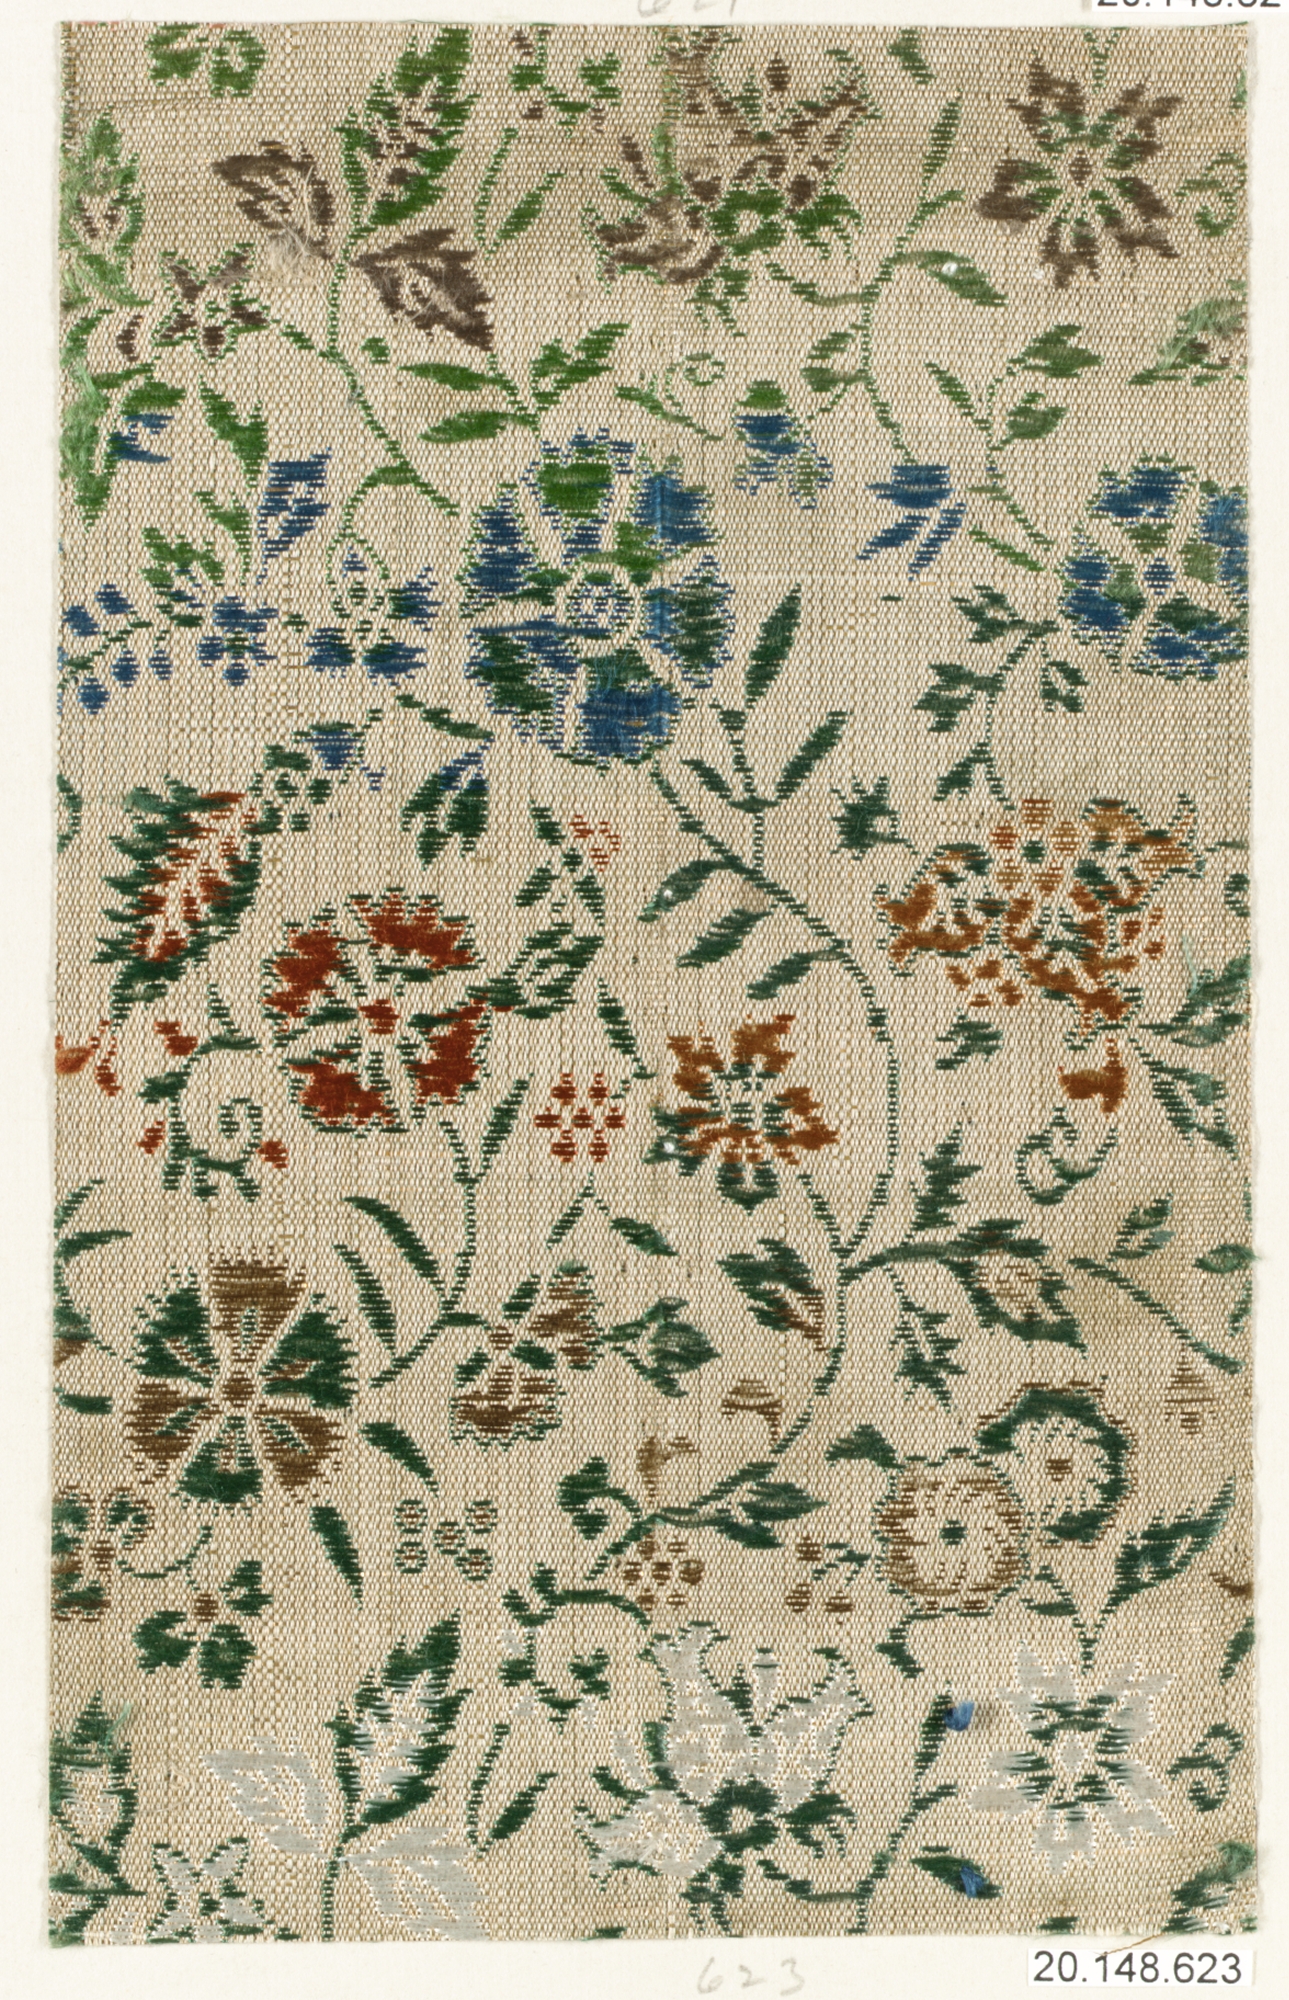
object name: piece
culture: japanese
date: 1701-1800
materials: silk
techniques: compound weave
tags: flowers,leaves